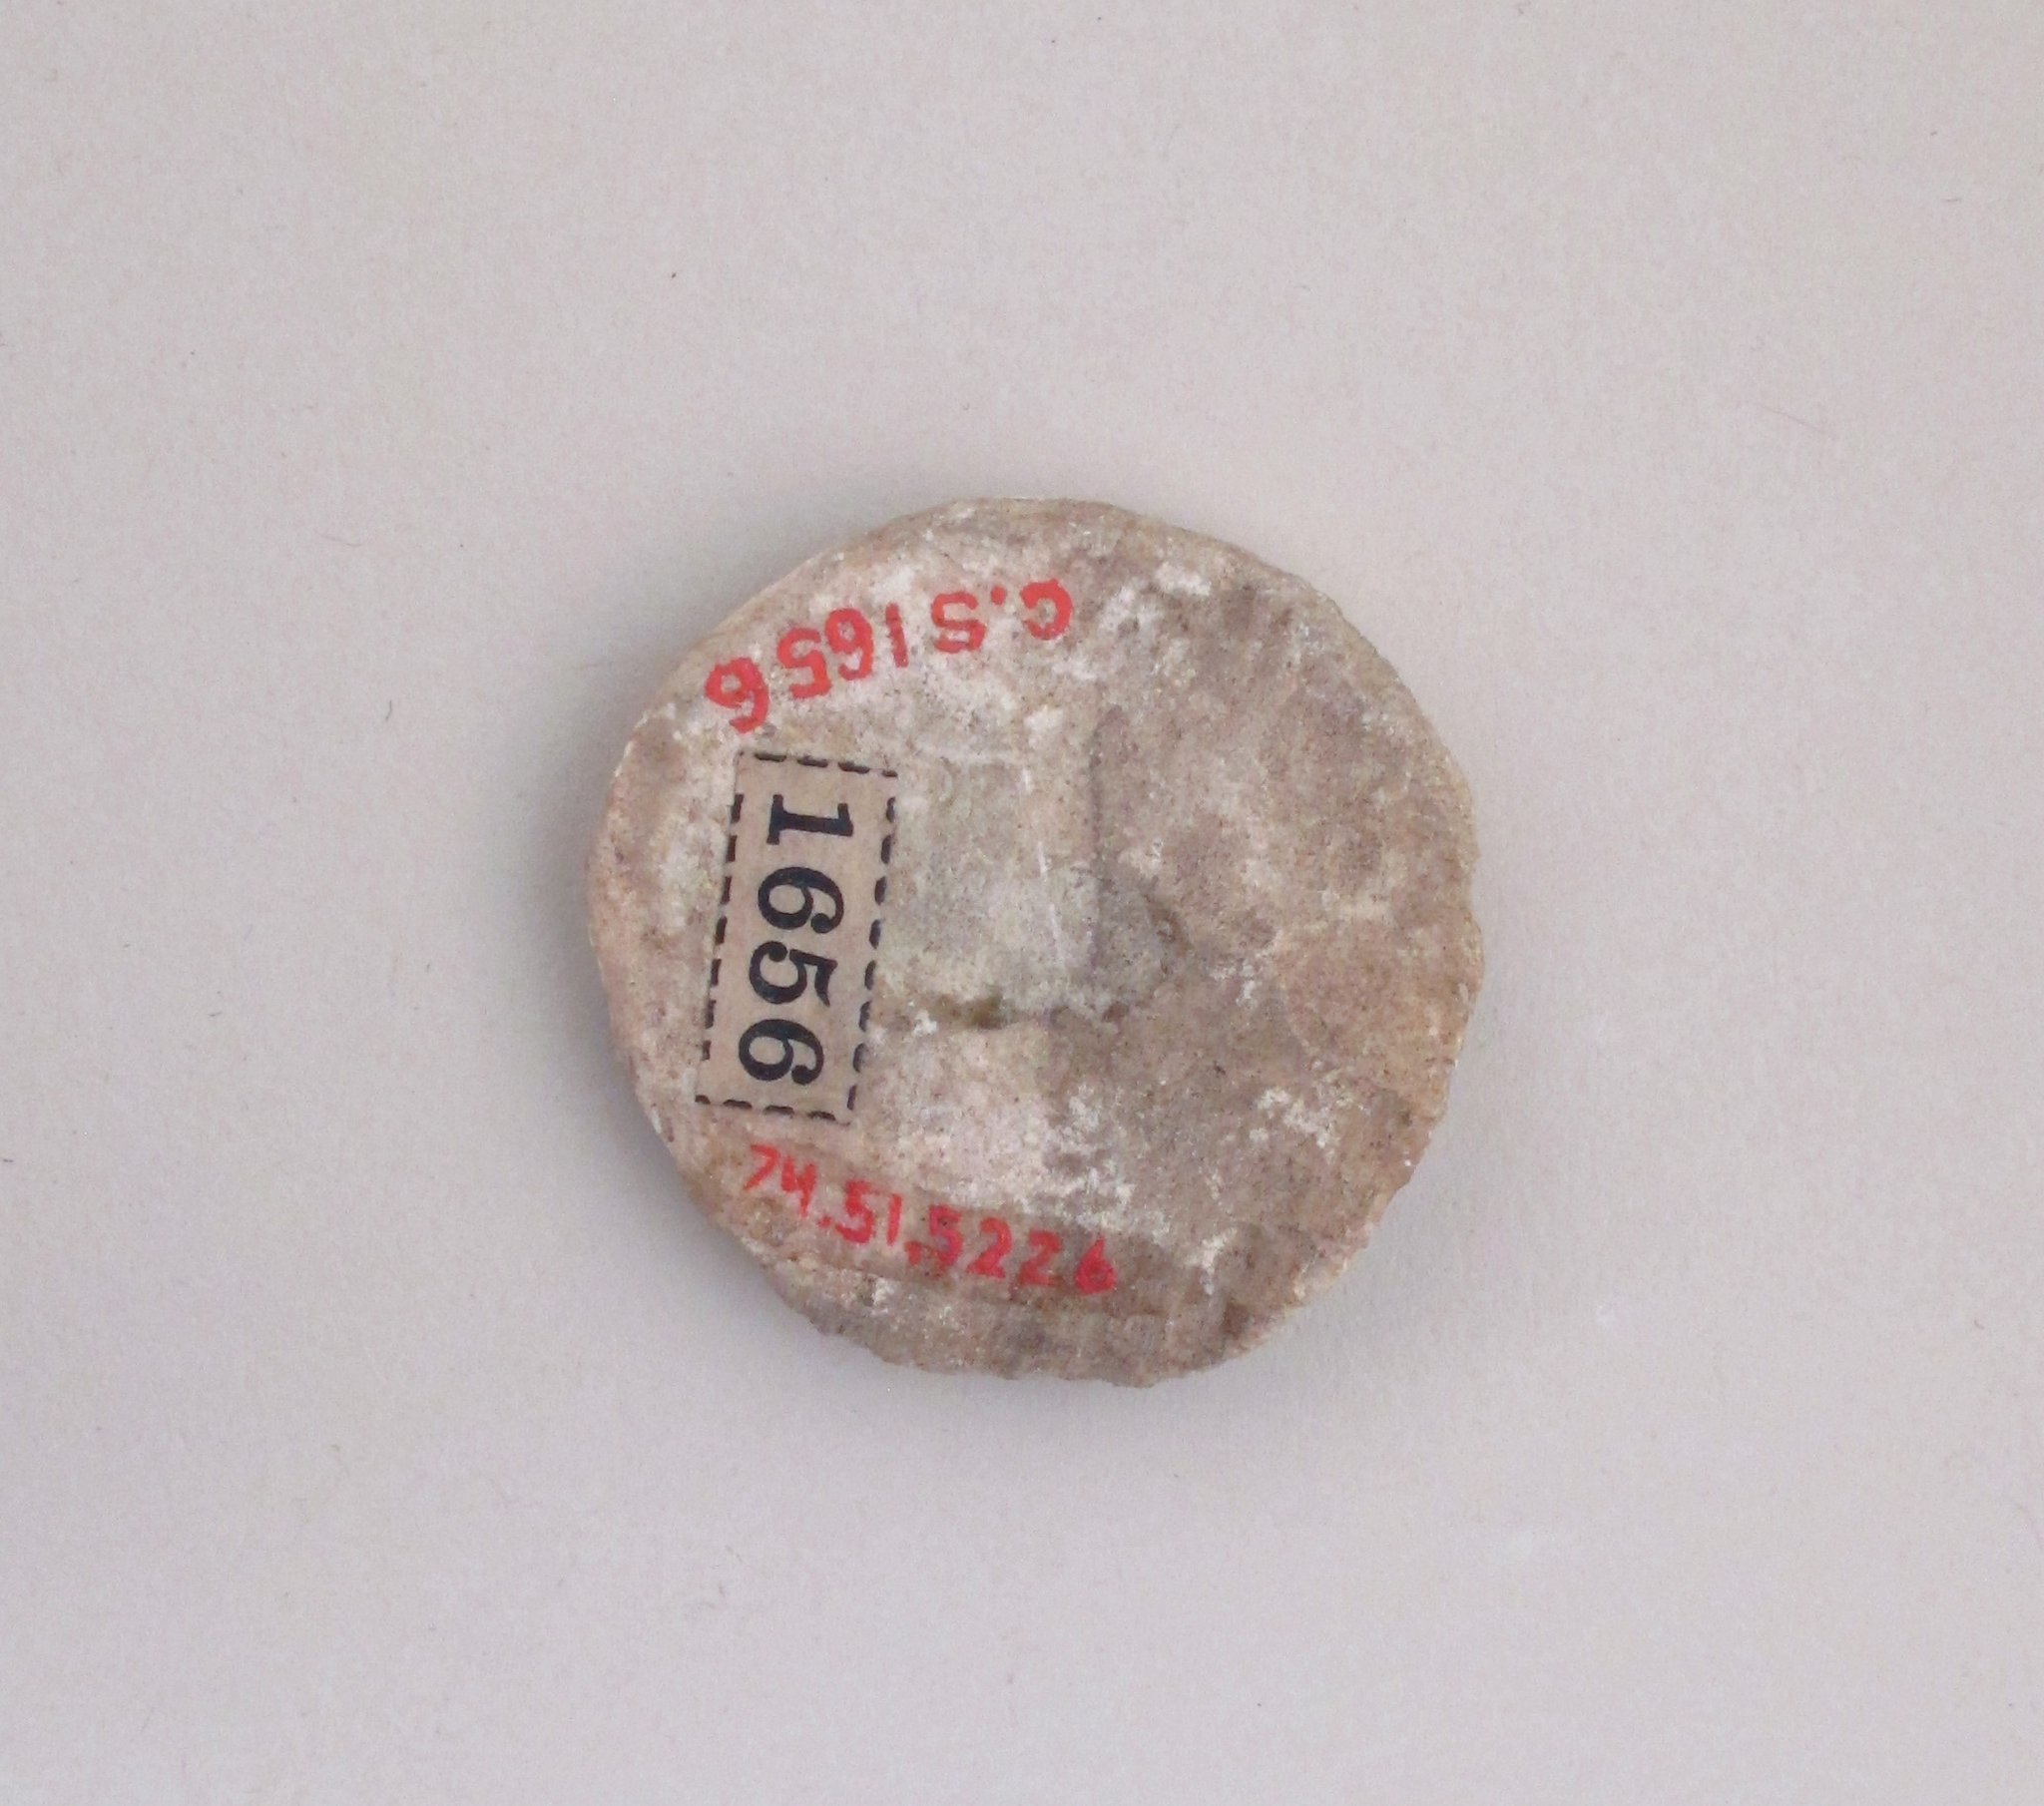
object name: roundel, disk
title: Ivory disk of a pyxis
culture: cypriot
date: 1300-1101 BCE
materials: ivory